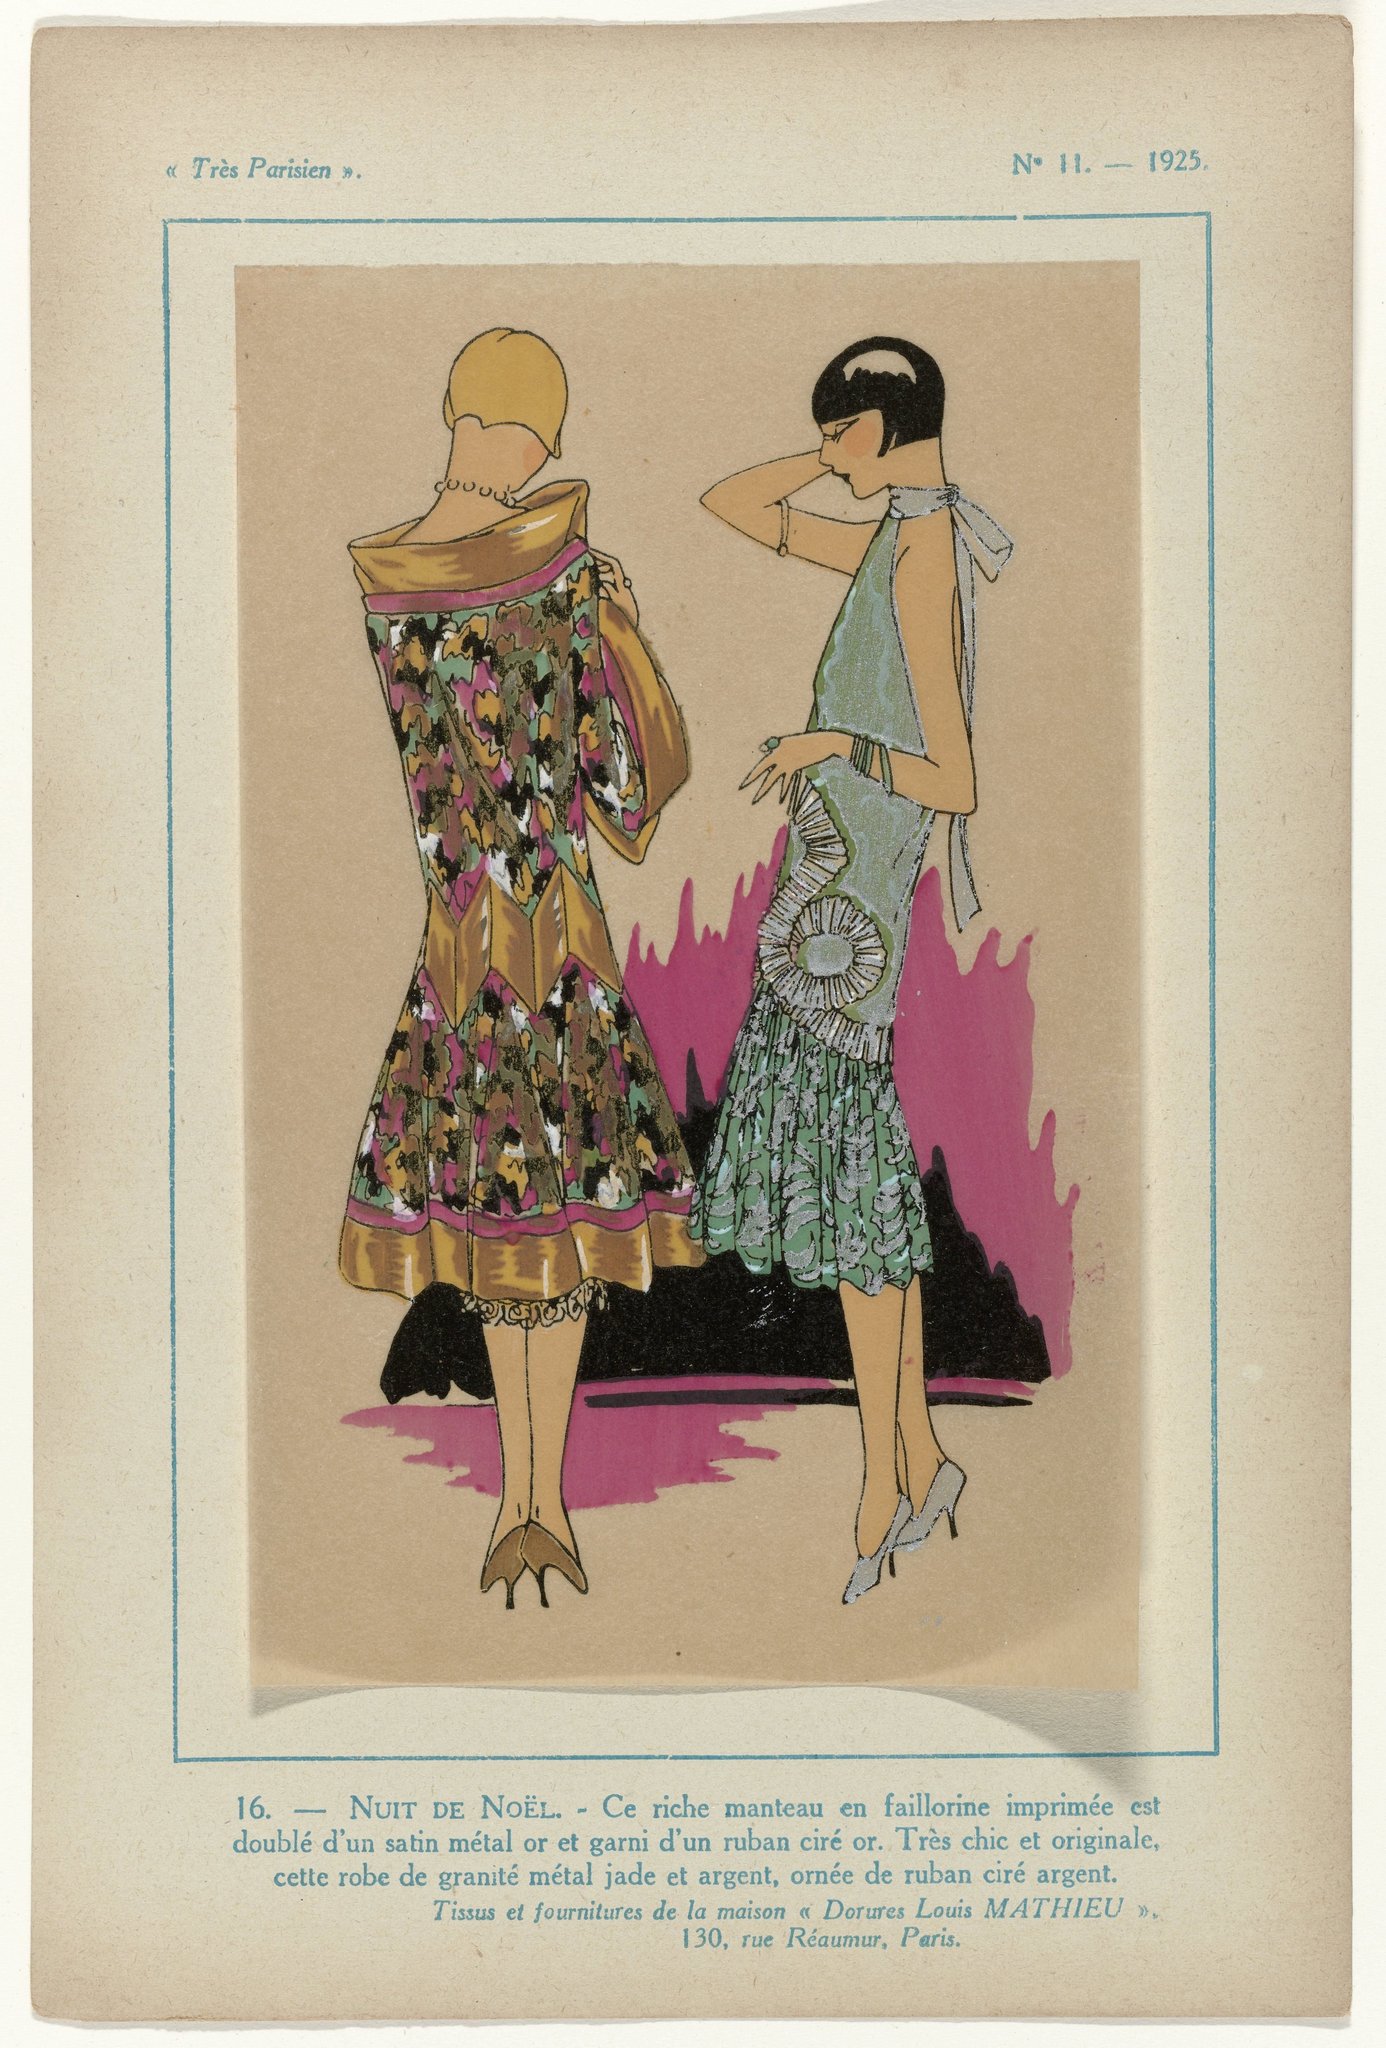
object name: fashion print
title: Très Parisien, 1925, No. 11, Pl. 16:- NUIT DE NOËL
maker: g-p. joumard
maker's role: publisher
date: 1925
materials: paper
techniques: hand coloring, letterpress printing, lithography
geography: paris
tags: dress, gown (afternoon dress) (+ women's clothes), fashion plates, bracelet, wristlet (+ women's clothes)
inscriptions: caption: ‘16. - NUIT DE NOËL. - Ce riche manteau en faillorine imprimée est doublé d'un satin métal or et garni d'un ruban ciré or. Très chic et originale, cette robe de granité métal jade et argent, ornée de ruban ciré argent.’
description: Mantel en japon van maison 'Dorures Louis MATHIEU', Parijs. Prent uit het modetijdschrift Très Parisien...La Mode, Le Chic, L'Élégance (1920-1936)